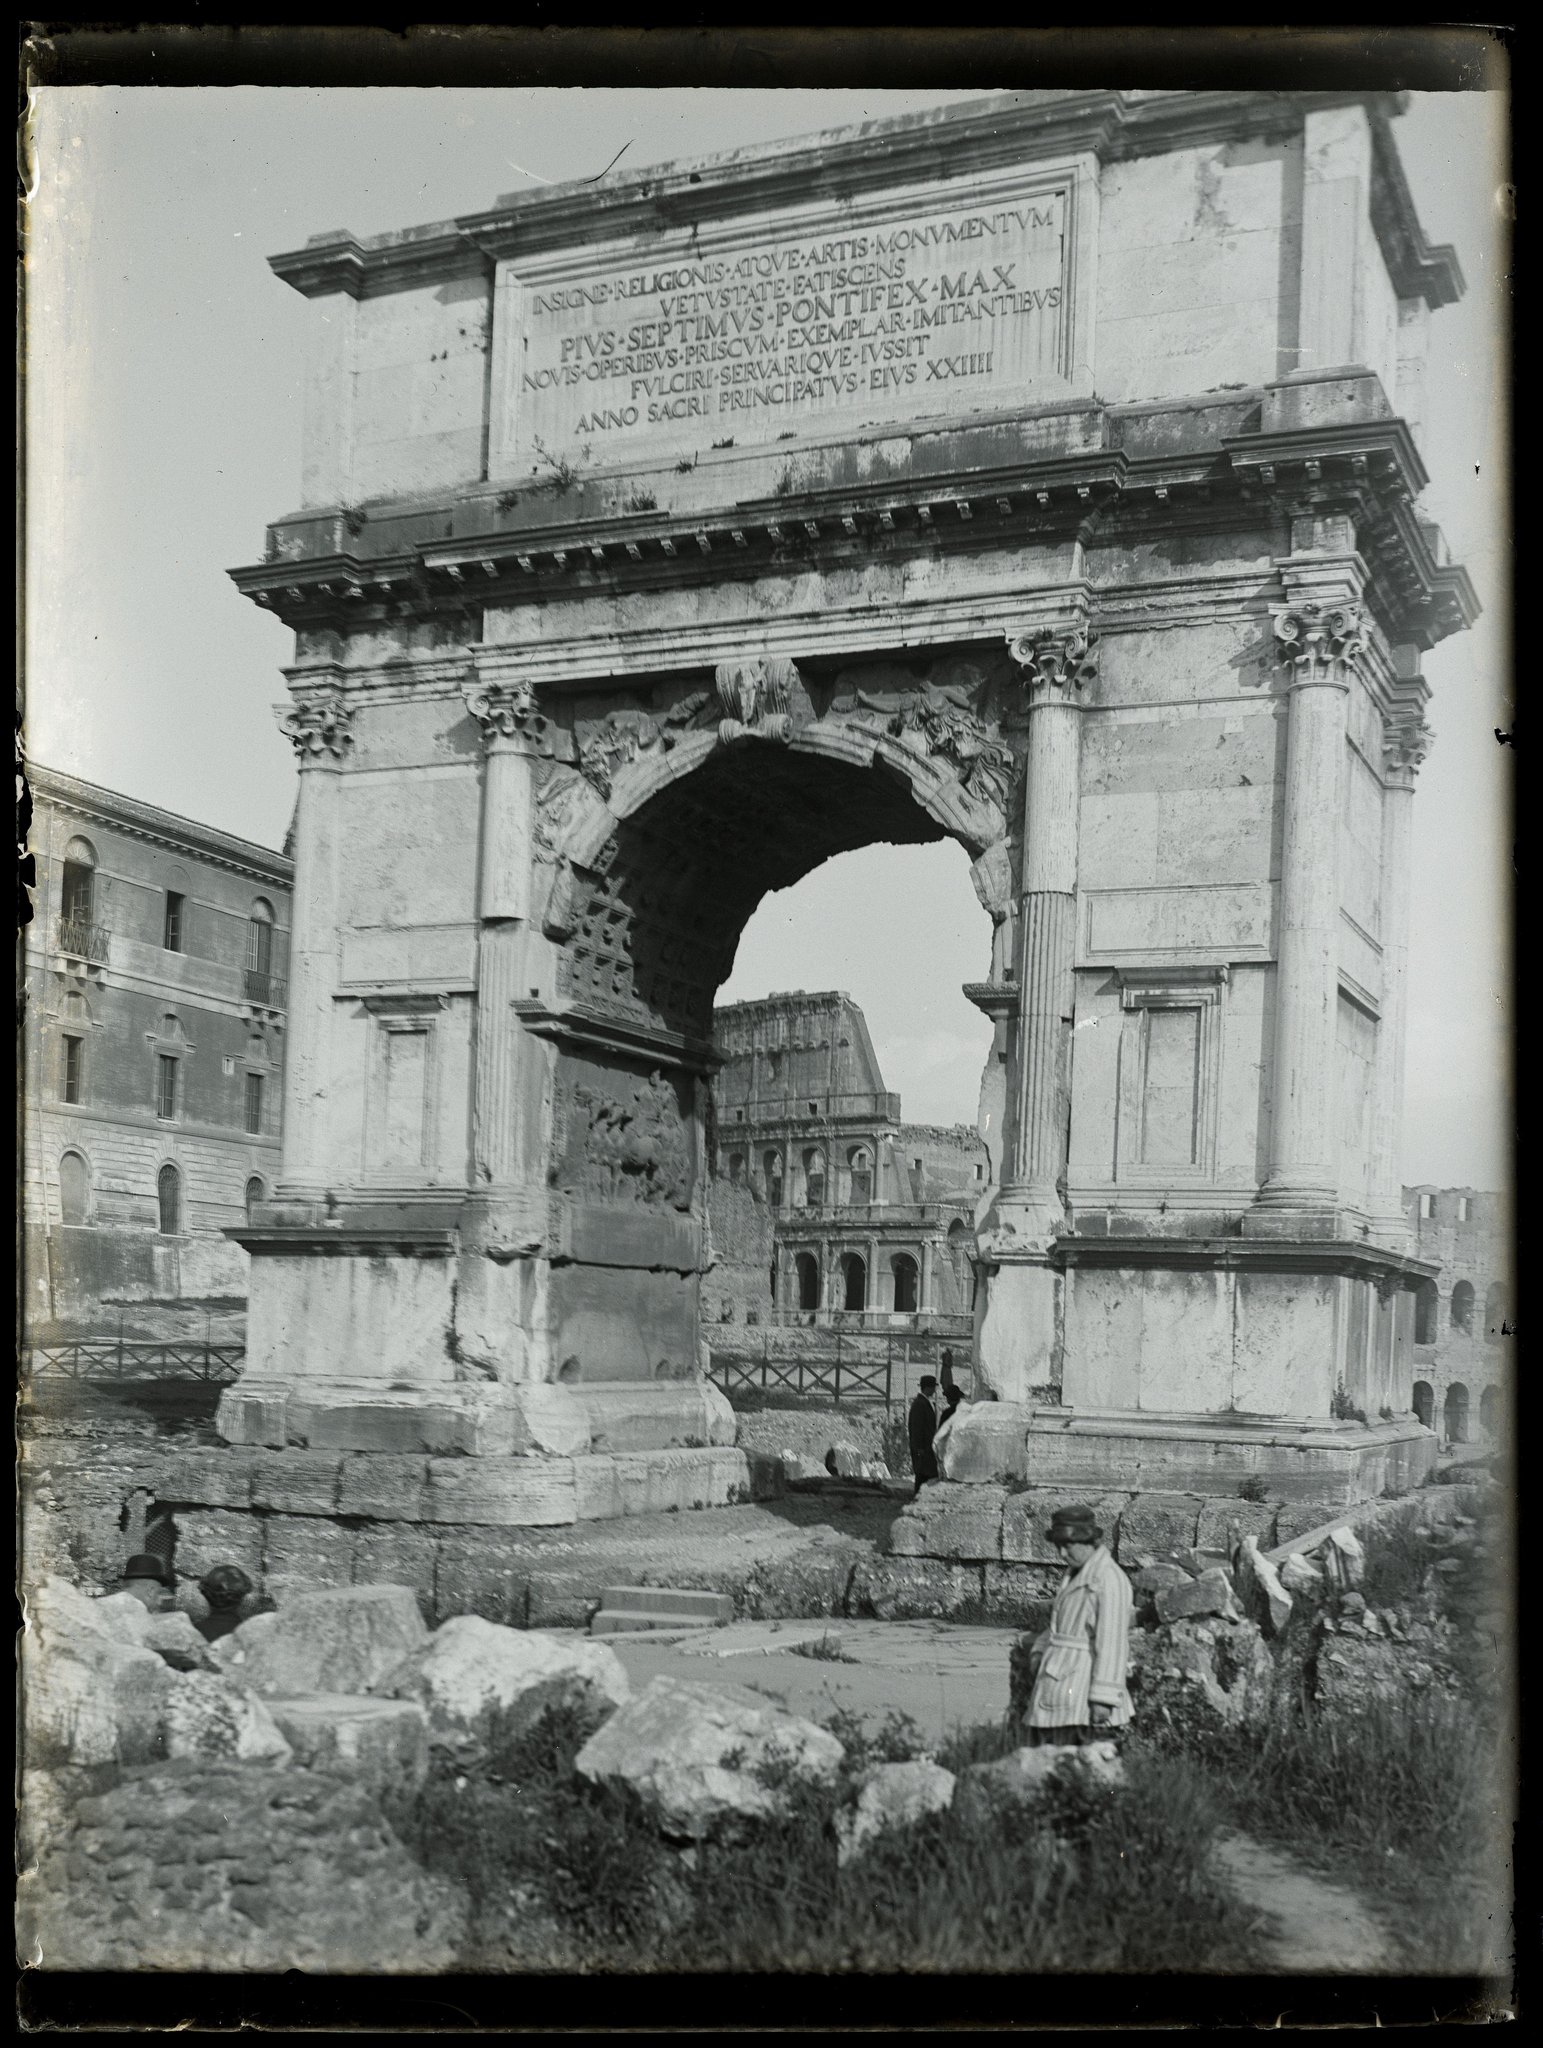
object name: glasnegatief, glasplaatnegatief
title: Boog van Titus op het Forum Romanum, op de achtergrond het Colosseum, te Rome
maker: Anonymous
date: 1907-1935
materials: glass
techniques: gelatin glass negative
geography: rome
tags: triumphal arch